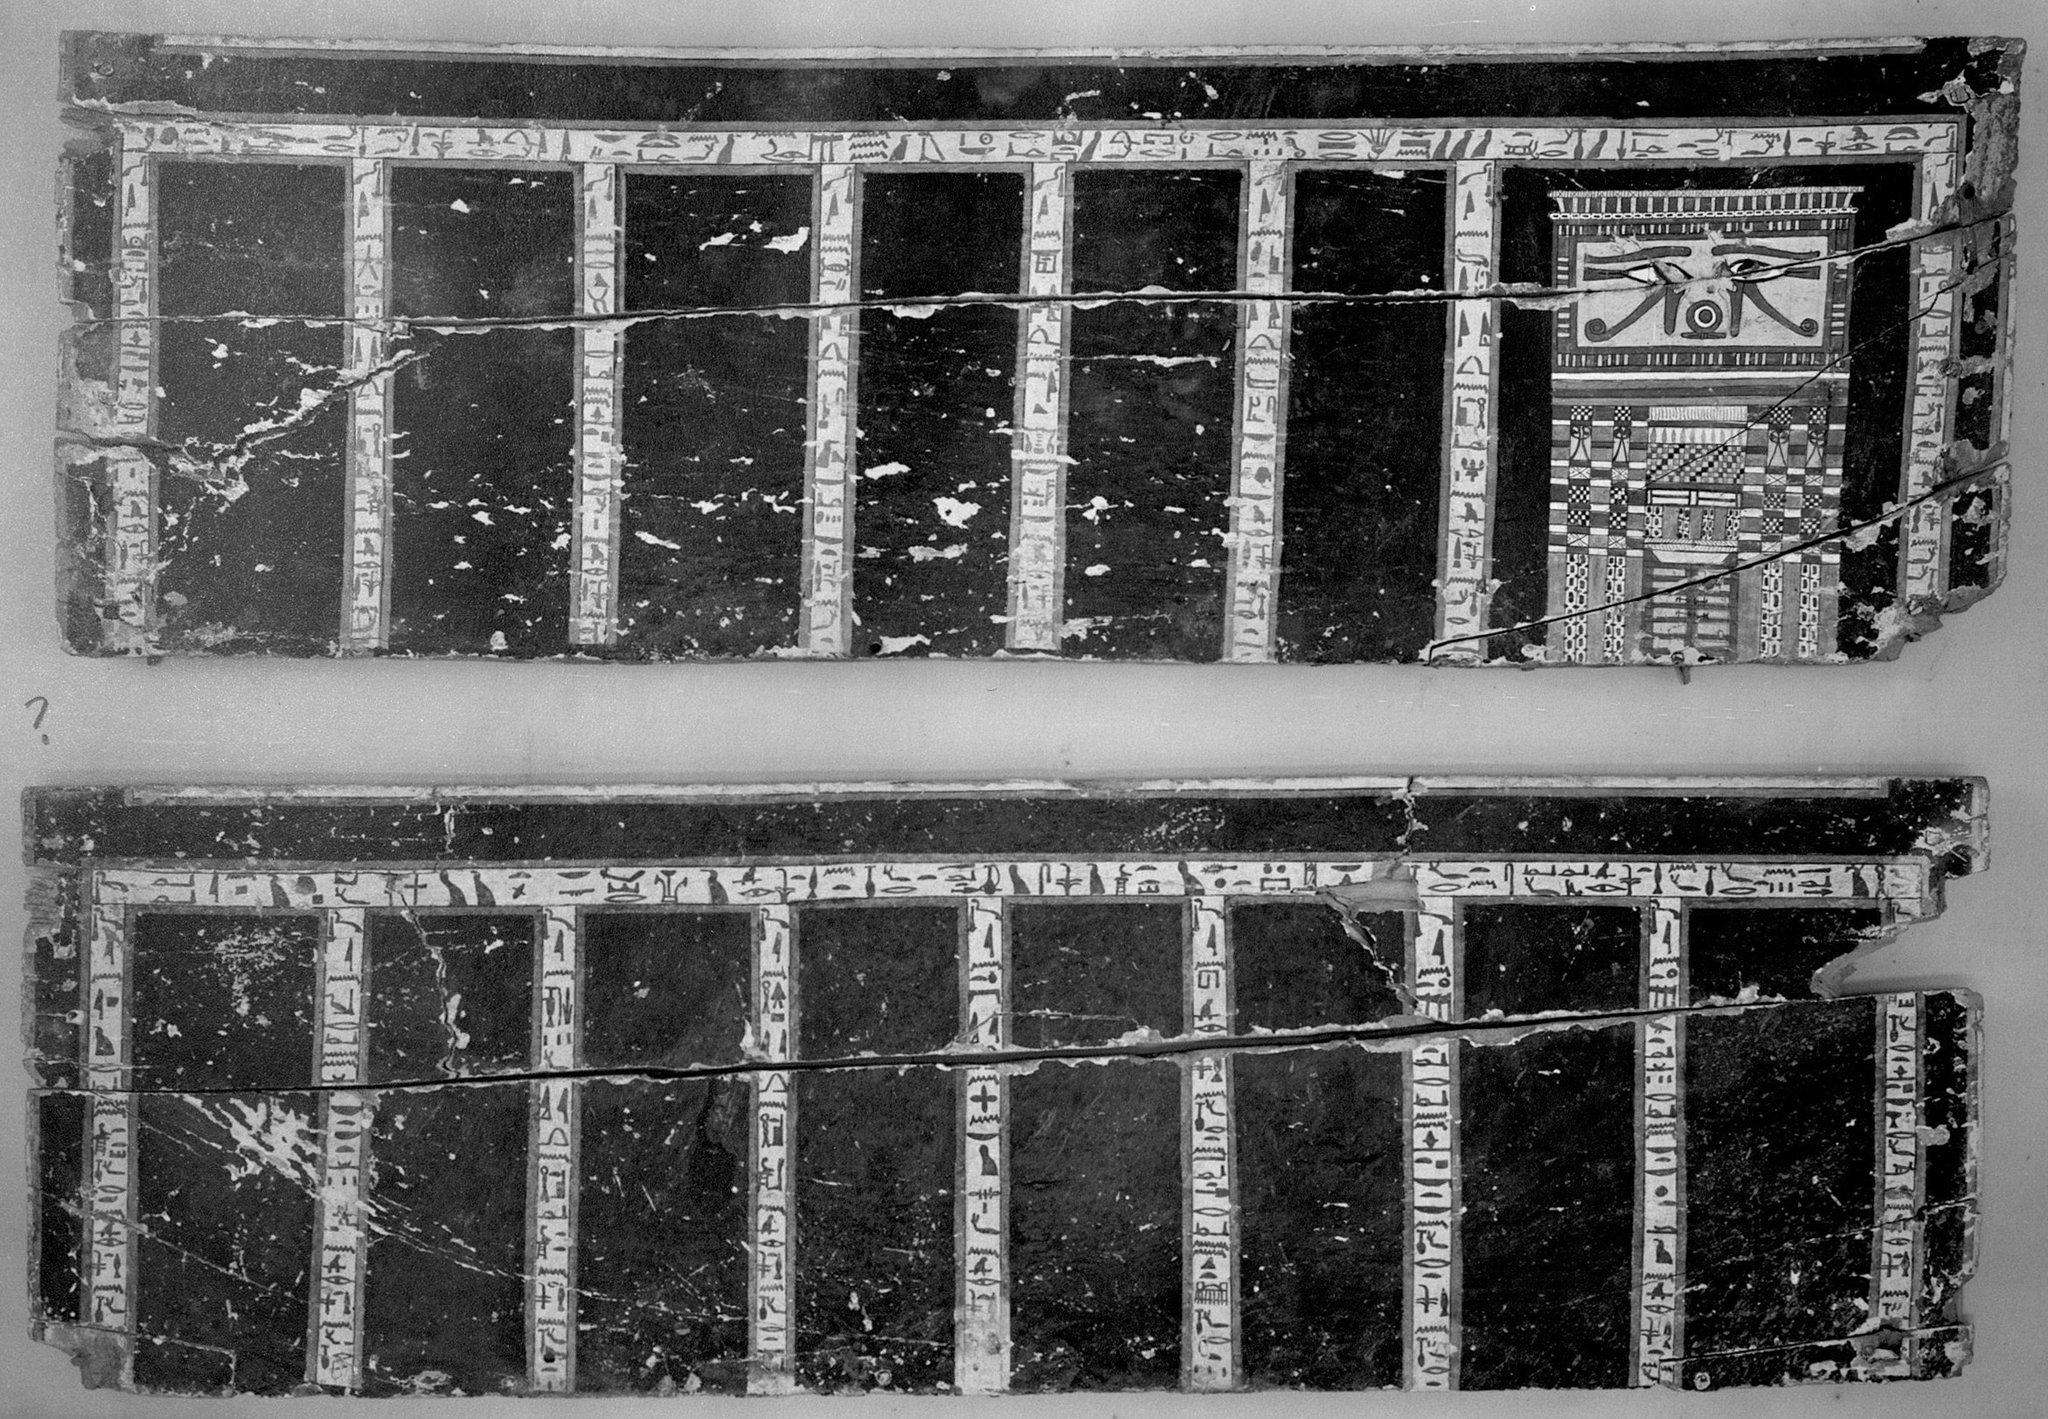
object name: coffin, nefnefret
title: Coffin of Nefnefret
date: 1802-1640 BCE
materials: paint, wood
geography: egypt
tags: hieroglyphs,coffins